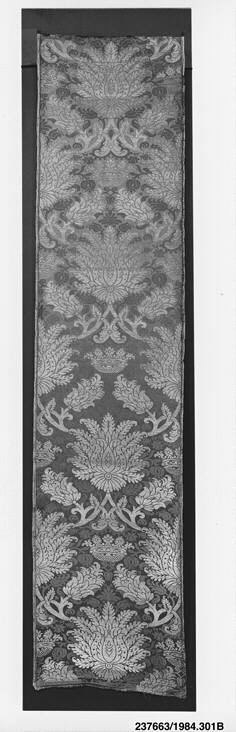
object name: panel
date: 1601-1700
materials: metal thread, silk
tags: flowers